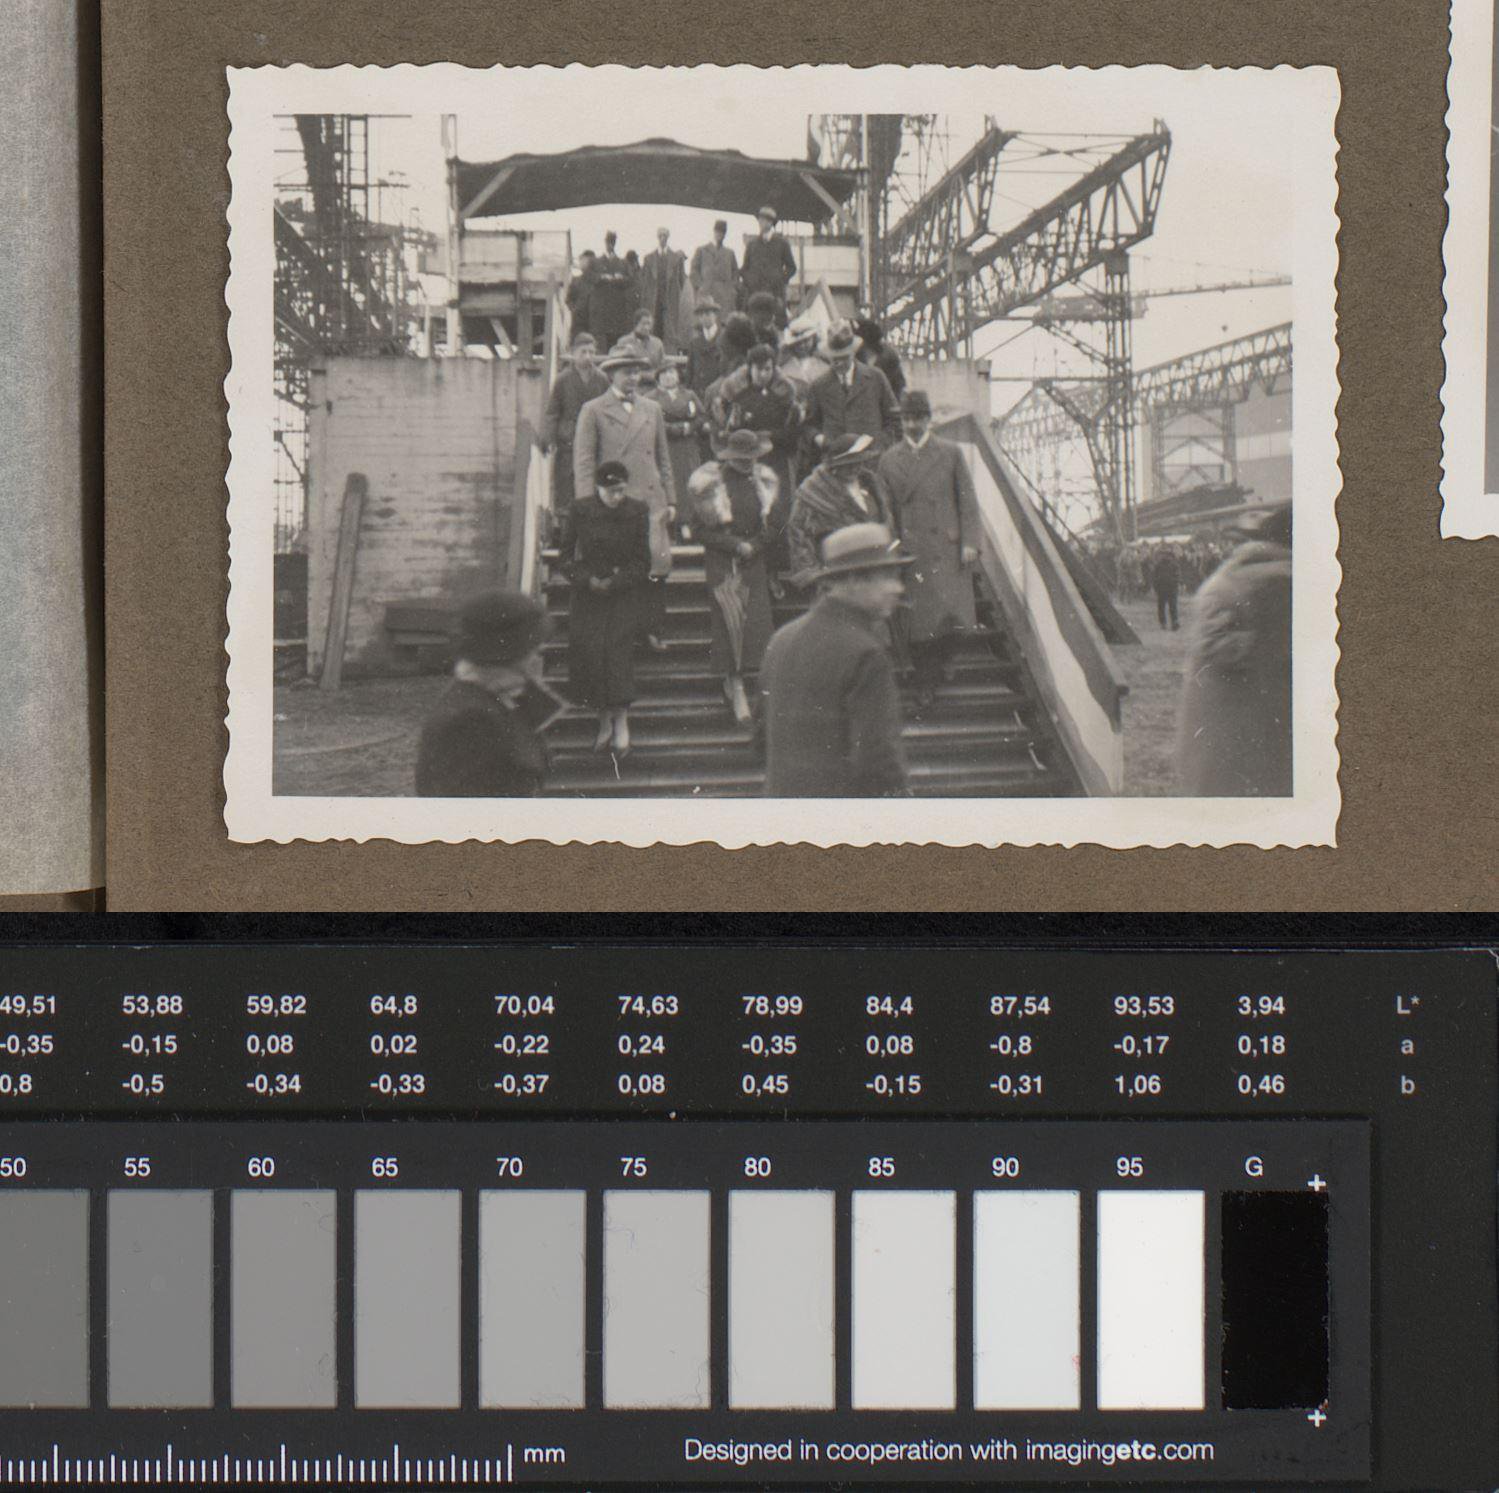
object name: album leaf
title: Gezelschap op een trap bij de Rotterdamse Droogdok-Maatschappij, bij de doop van het schip Sunetta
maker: Anonymous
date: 1934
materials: paper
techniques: gelatin silver print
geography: rotterdam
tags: christening a ship, dry-dock, floating-dock, rotterdam